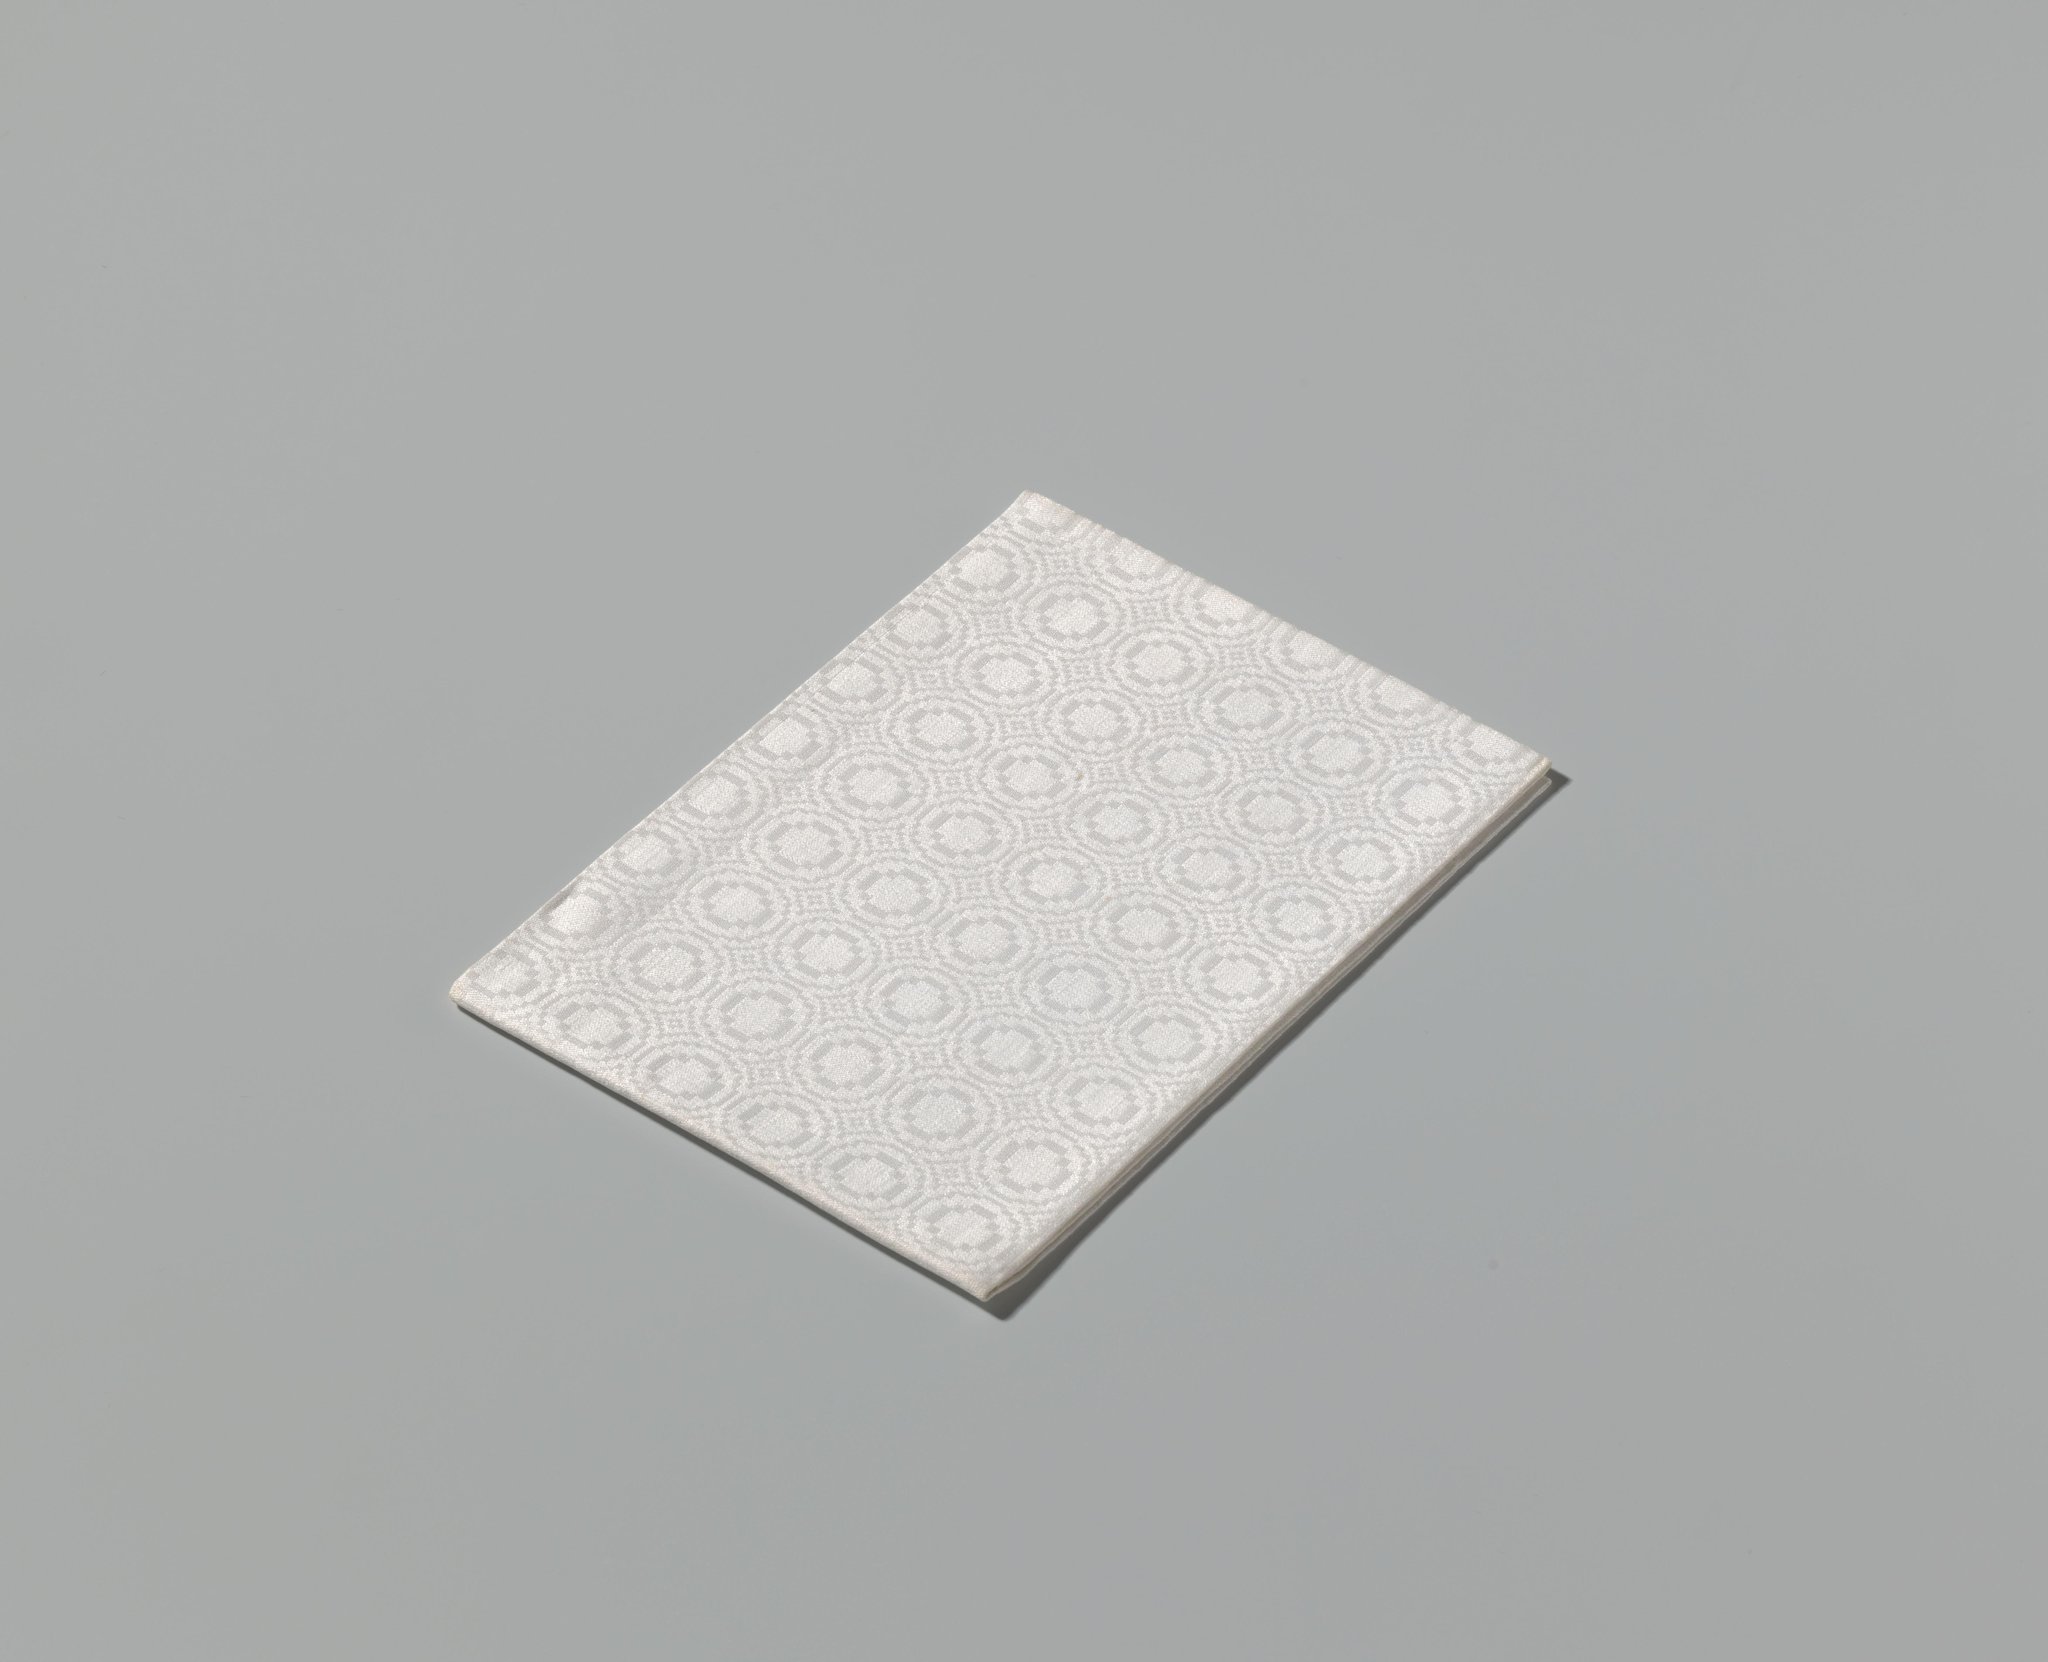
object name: napkin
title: Servet van linnen met pellenpatroon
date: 1600-1650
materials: linen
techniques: peeled fabric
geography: northern netherlands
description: wit linnen servet met pellen patroon, merk IVG